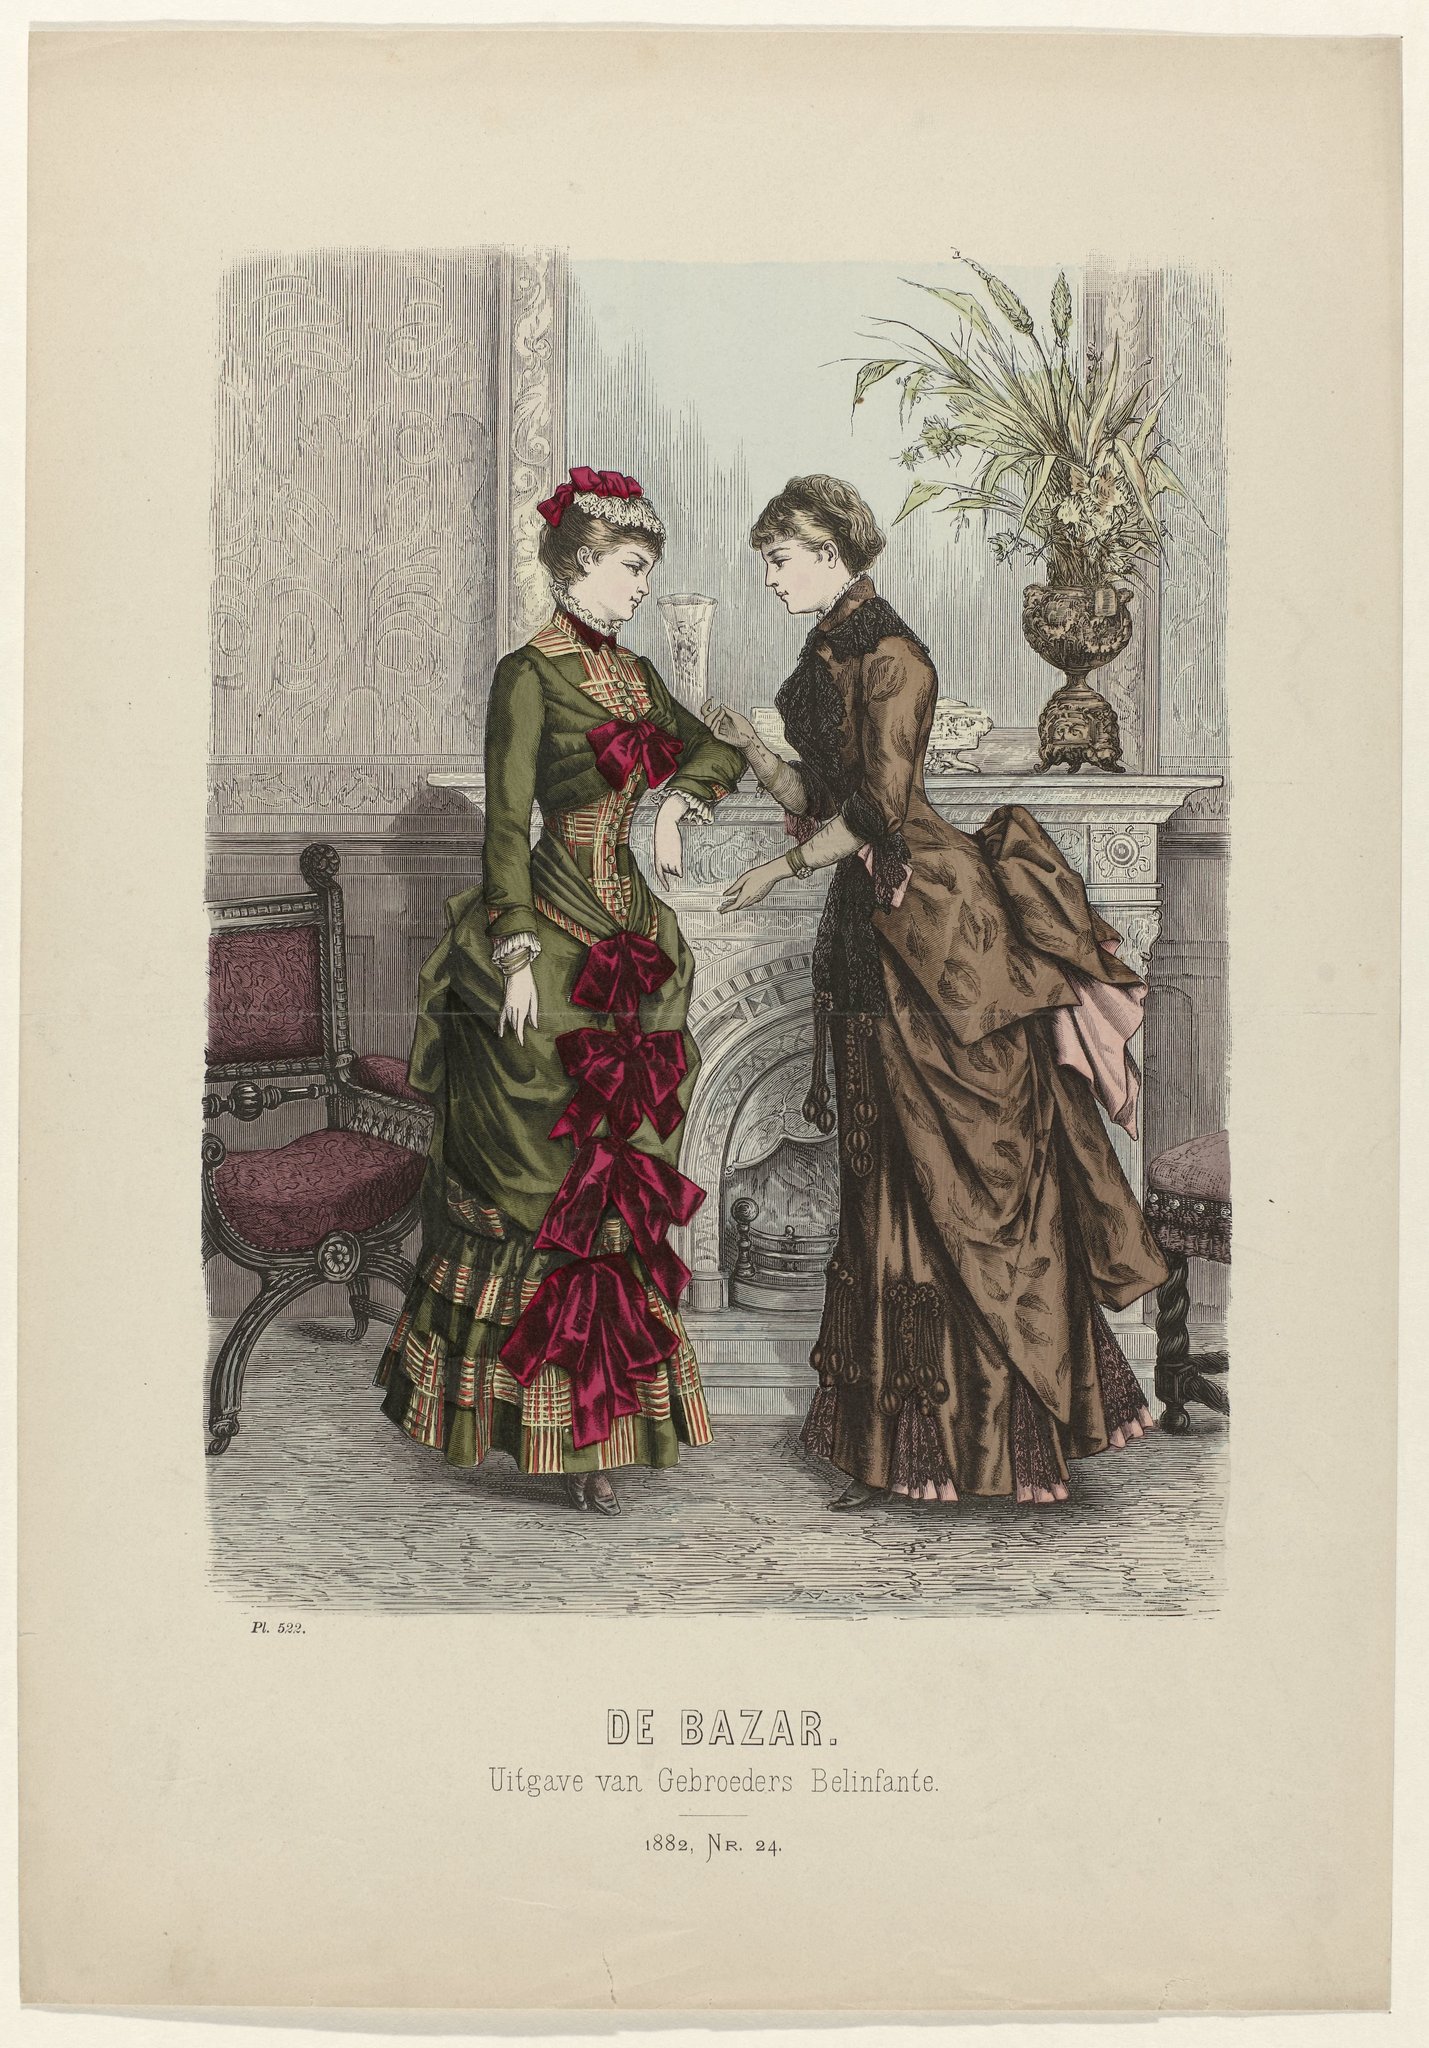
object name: fashion print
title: De Bazar, 1882, Nr. 24, Pl. 522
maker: Anonymous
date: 1882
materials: paper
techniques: hand coloring, engraving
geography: the hague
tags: bow (ornamental part of clothing) (+ women's clothes), gloves, mittens (long gloves) (+ women's clothes), open hearth, fire-place, head-gear: cap (+ women's clothes), fashion plates, dress, gown (+ women's clothes), bracelet, wristlet (+ women's clothes)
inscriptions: caption: ‘DE BAZAR. / Uitgave van Gebroeders Belinfante. / 1882, Nr. 24’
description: Prent uit het modetijdschrift De Bazar, geïllustreerd Tijdschrift voor Modes en Handwerken (1857-1900).